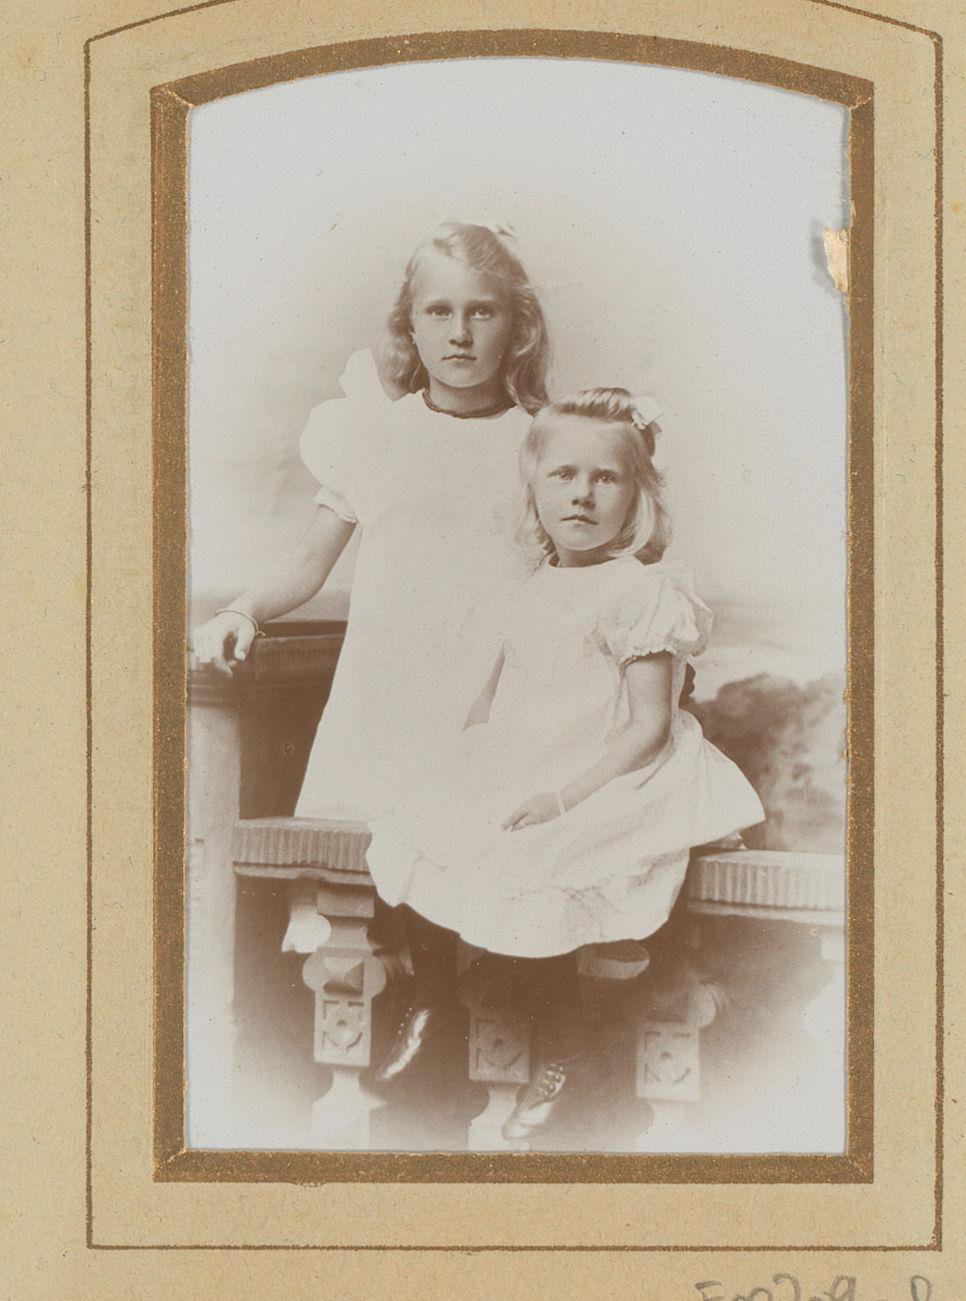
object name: carte de visite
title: Portret van een twee meisjes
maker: f. engel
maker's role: artist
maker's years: 1872-1958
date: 1896-1920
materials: cardboard, photographic support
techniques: collodion silver print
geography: zaandam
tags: girl (child between toddler and youth)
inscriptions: inscription: ‘Engel/ Zaandam/ Westzijde’